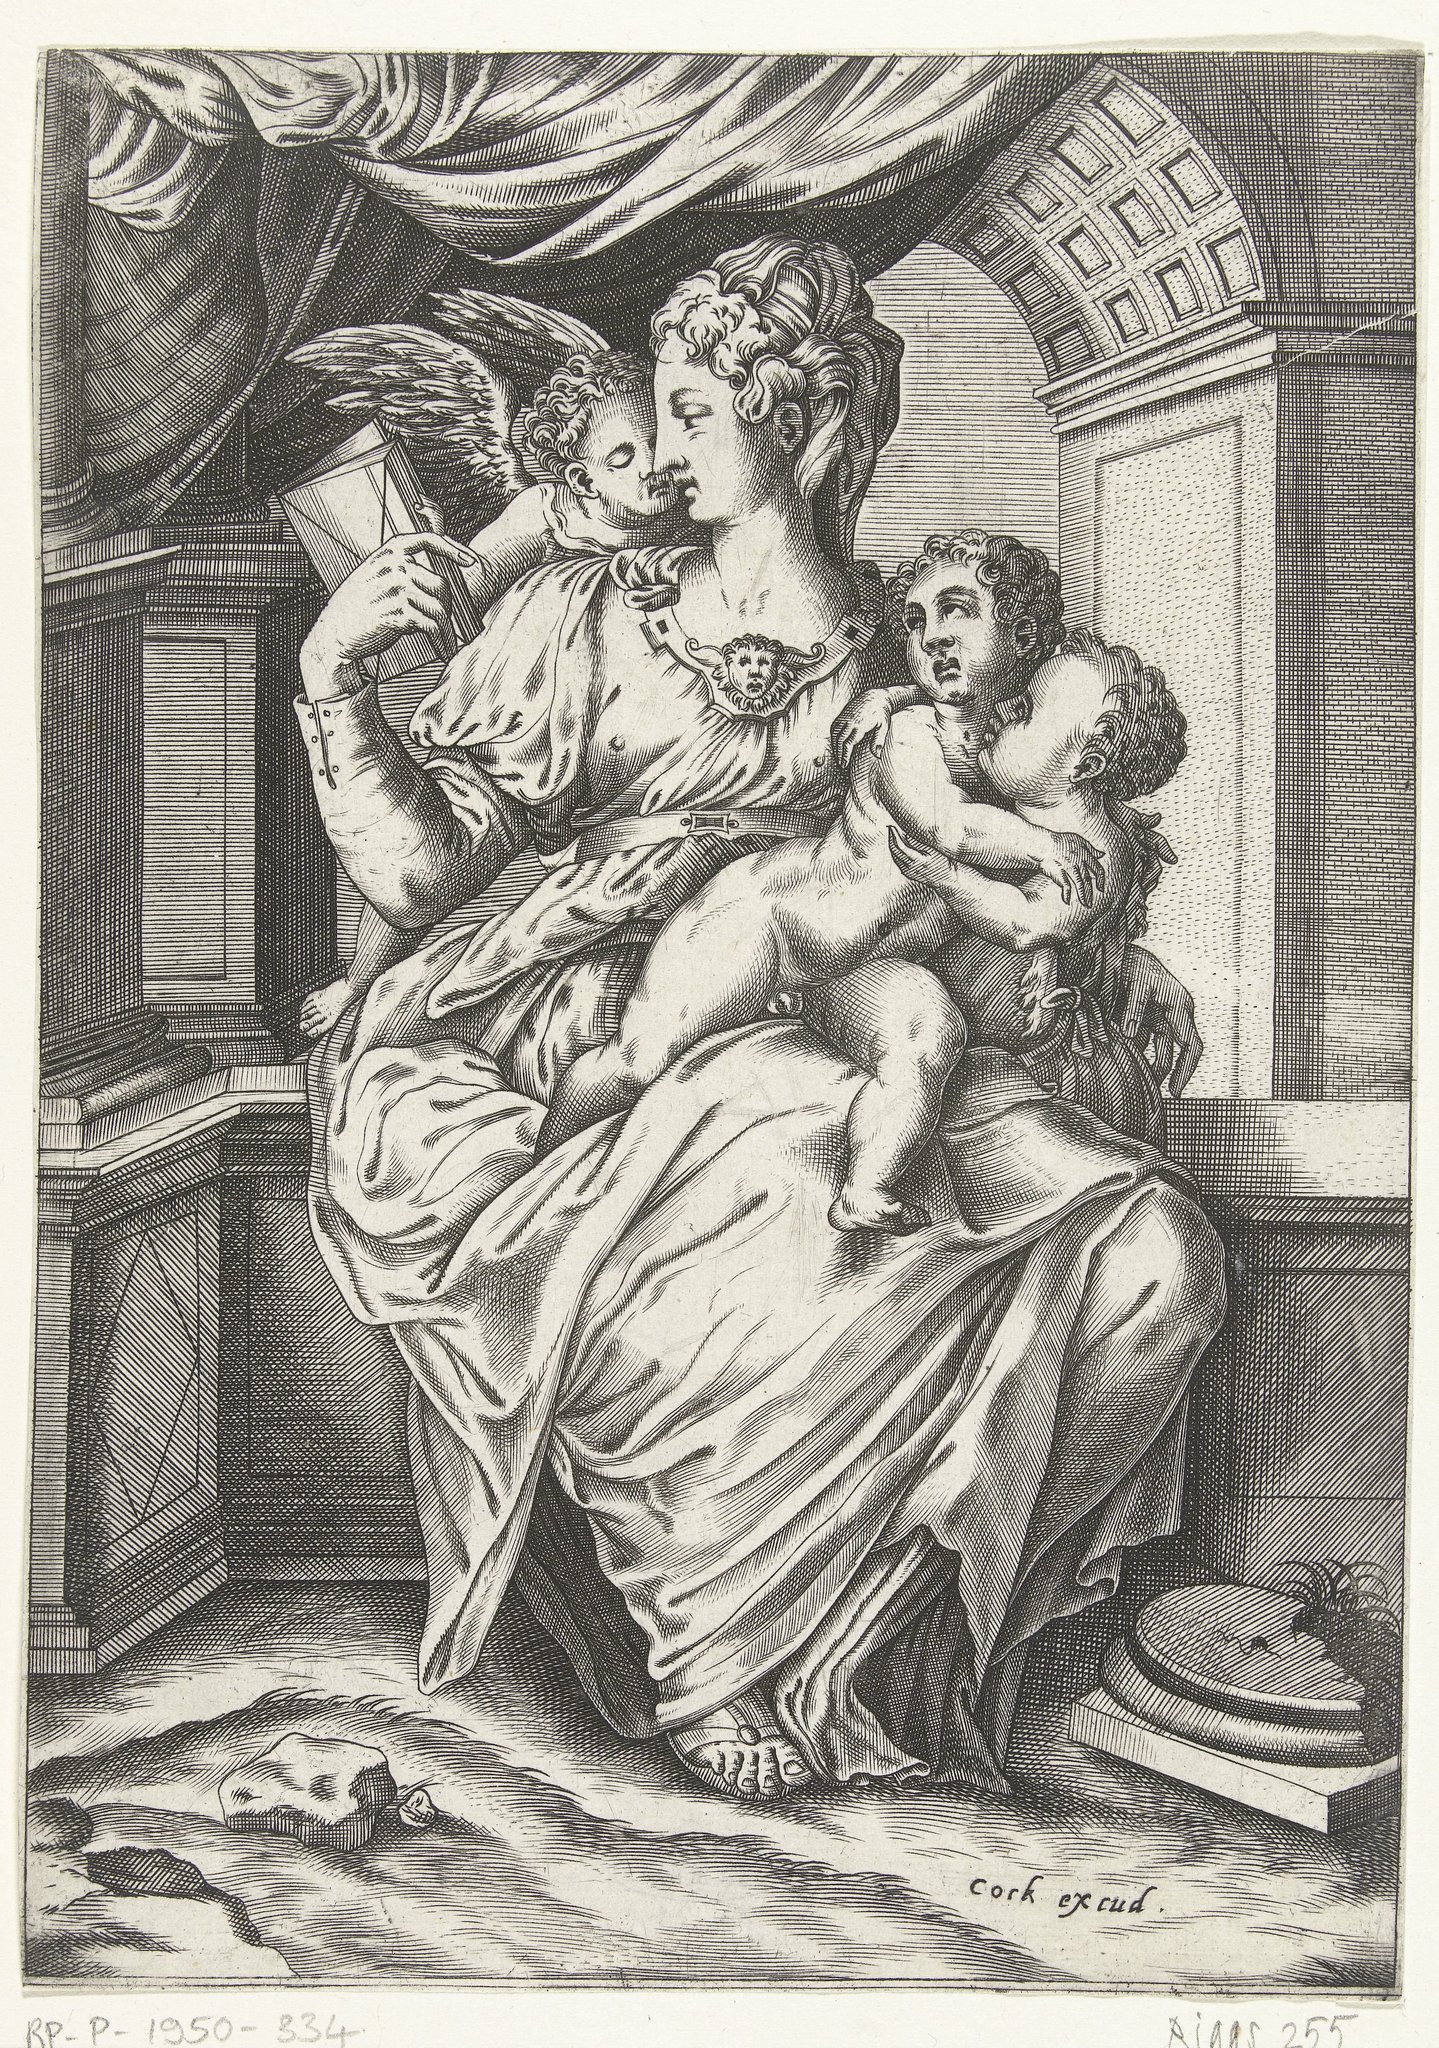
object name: print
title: Maria met het Kind, Johannes de Doper en een engel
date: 1550-1570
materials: paper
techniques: engraving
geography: antwerp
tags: mary and the christ-child with john the baptist (as child) (+ angel(s))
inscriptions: collector's mark: Lugt 2228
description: Maria zit met het Kind op haar schoot in een antiek gebouw. Naast haar staat Johannes de Doper als kind. Hij speelt met het Christuskind terwijl Maria leest in een boek dat haar door een engel aangereikt wordt.